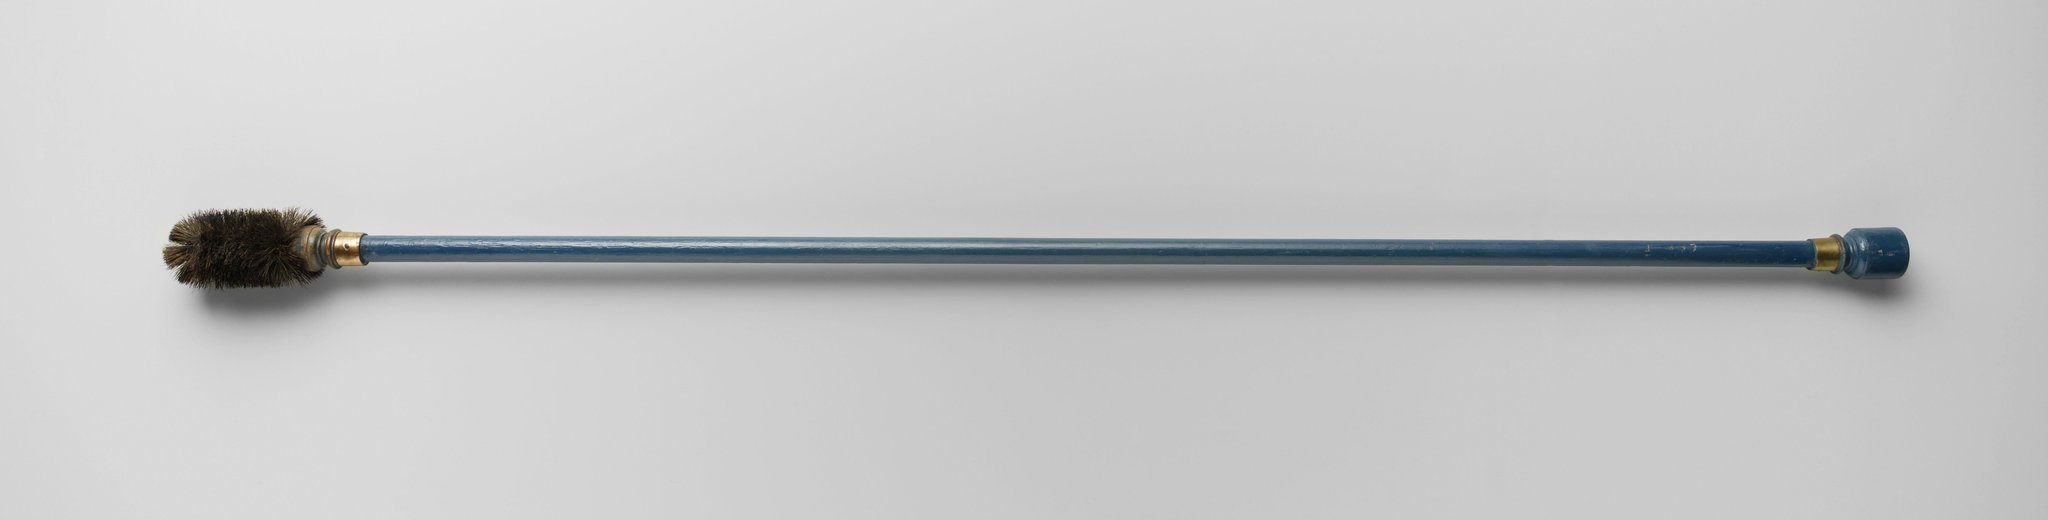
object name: rammer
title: Laadstok bij Singalees kanon of Lewuke's kanon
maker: Anonymous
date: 1745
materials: wood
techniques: painted, sawing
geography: sri lanka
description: Gerestitueerd object. Op 28 augustus 2023 tekende demissionair staatssecretaris Uslu voor Cultuur in Sri Lanka de eigendomsoverdracht van dit object. Vanaf die datum was het object in bruikleen van de Democratische Socialistische Republiek Sri Lanka. Op 28 november 2023 vond het transport naar Sri Lanka plaats. Gerestitueerd object. Op 28 augustus 2023 tekende demissionair staatssecretaris Uslu voor Cultuur in Sri Lanka de eigendomsoverdracht van dit object. Vanaf die datum was het object in bruikleen van de Democratische Socialistische Republiek Sri Lanka. Op 28 november 2023 vond het transport naar Sri Lanka plaats.